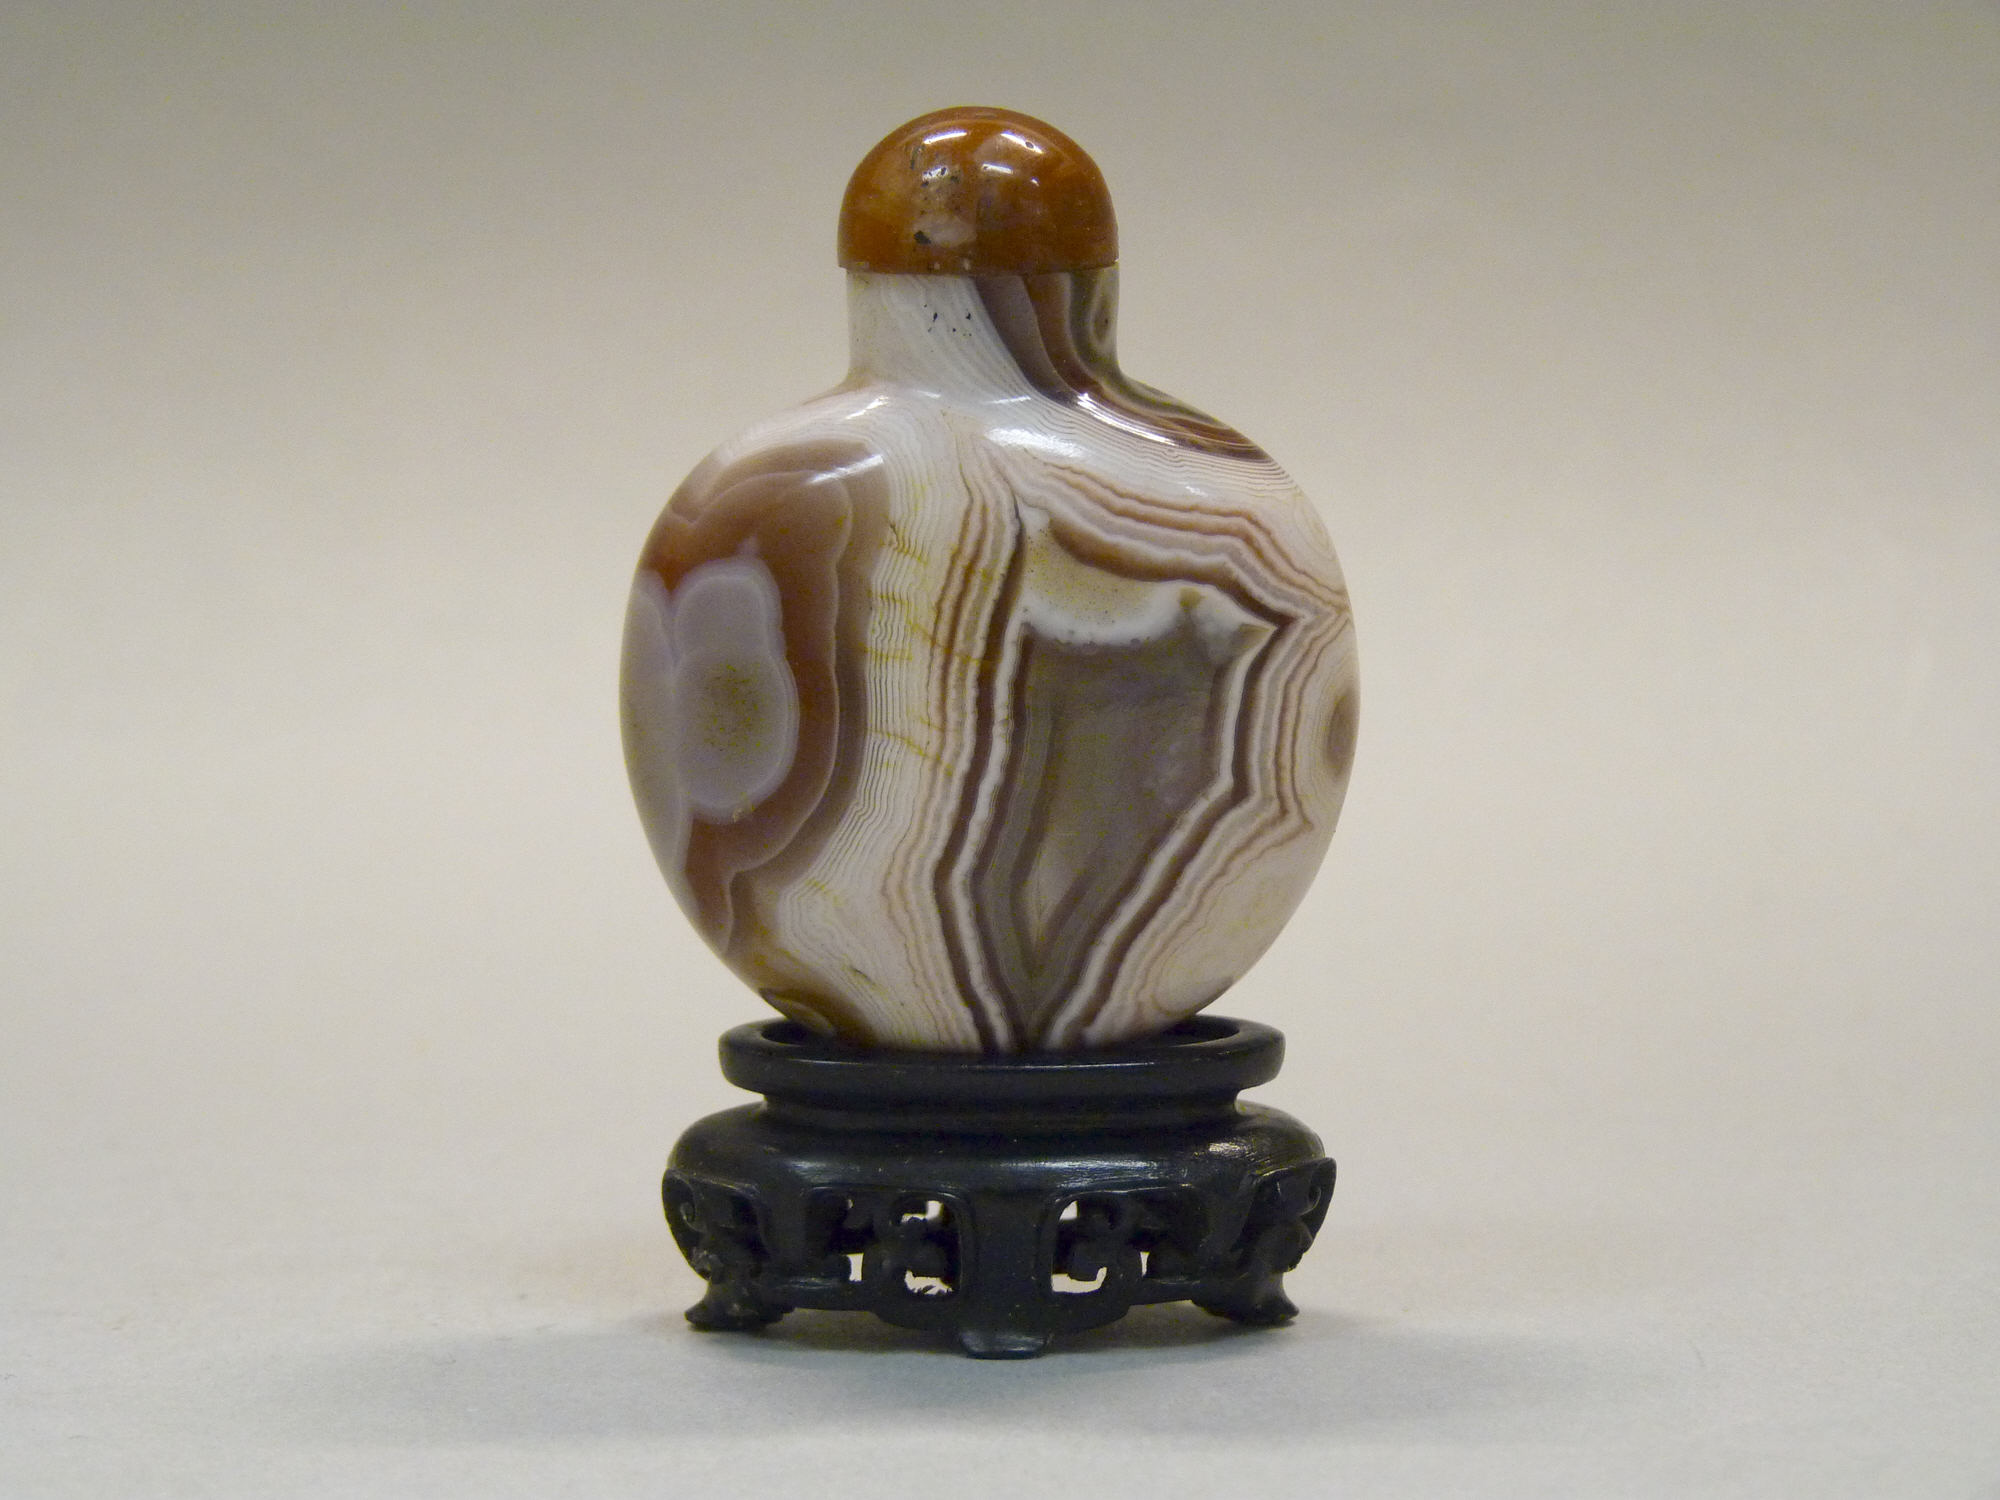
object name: snuff bottle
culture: chinese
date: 1801-1900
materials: stone, ribbon